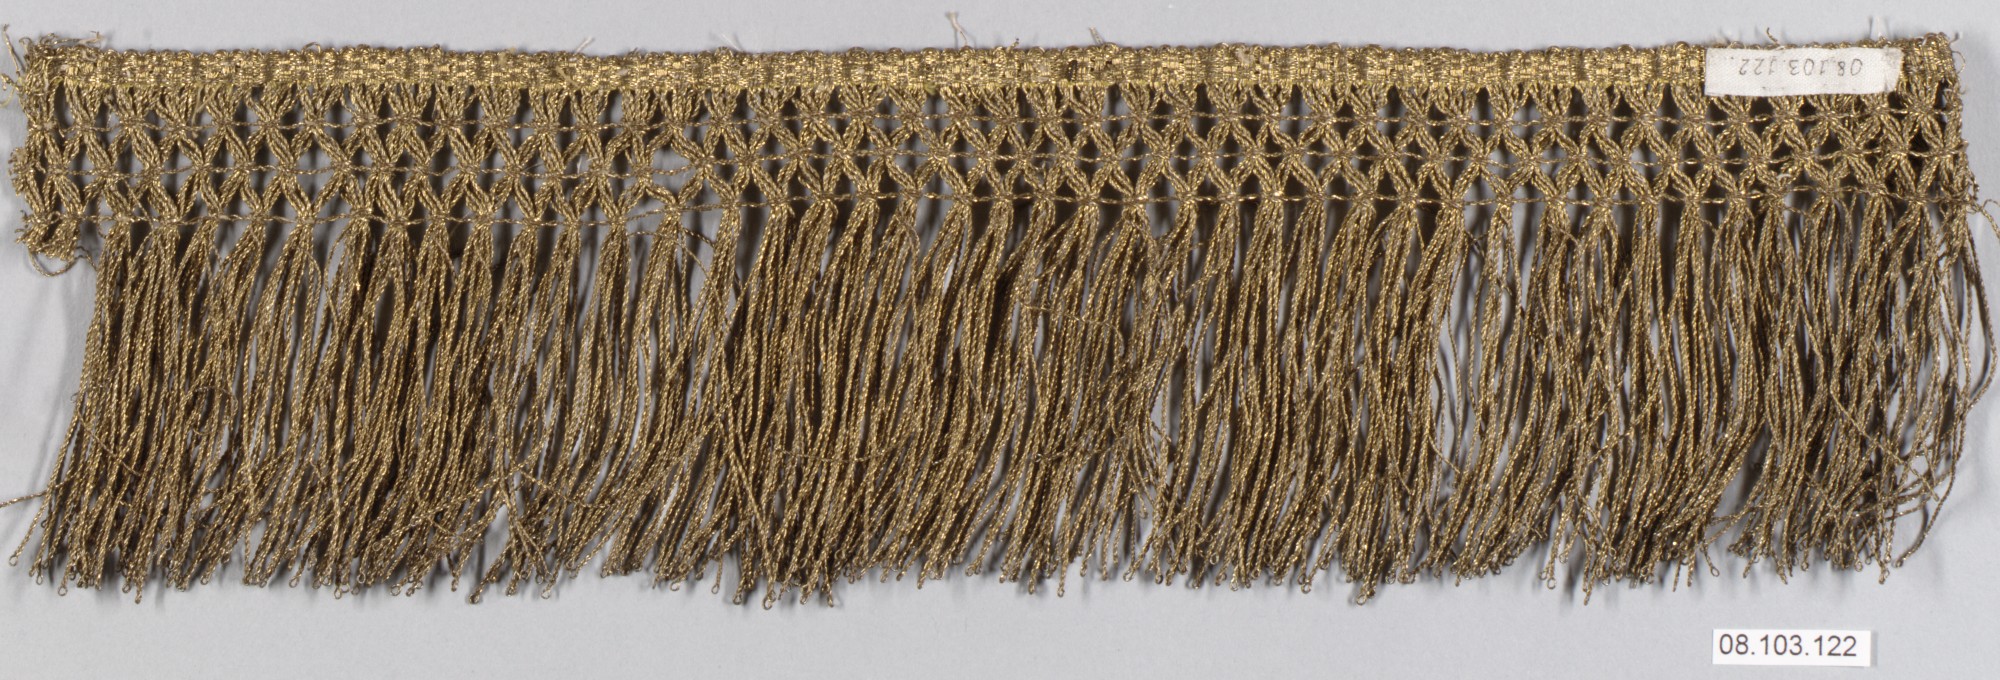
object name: fringe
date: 1801-1900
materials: metal thread